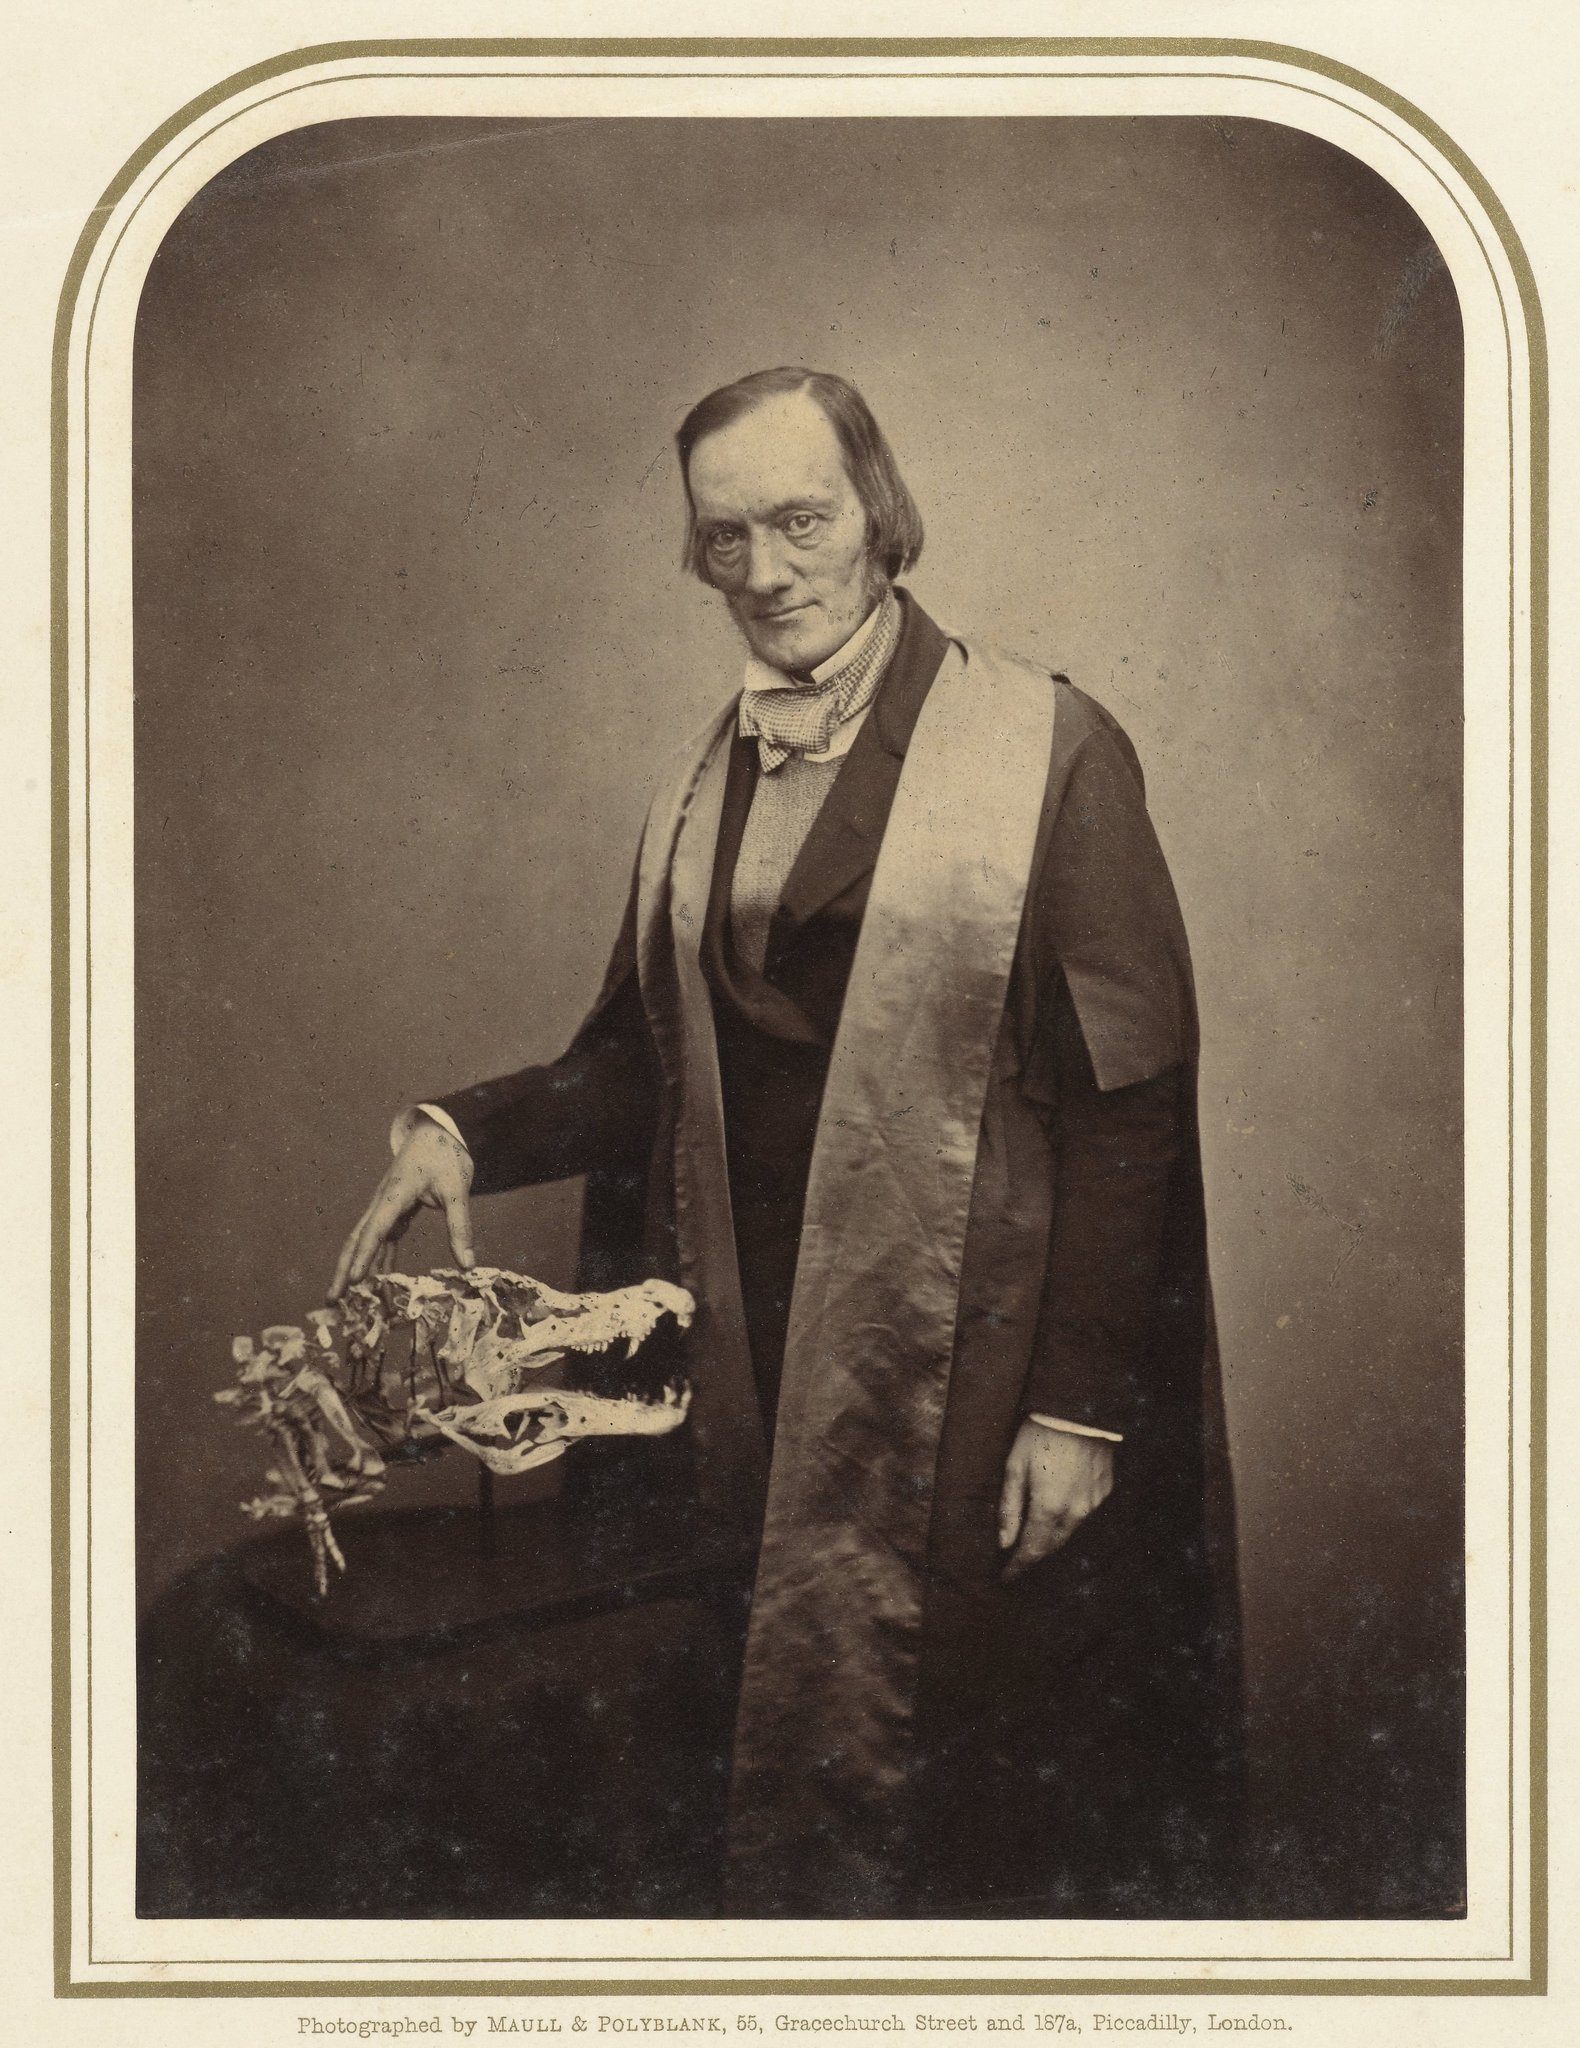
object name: photograph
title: Photographic Portraits of Living Celebrities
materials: paper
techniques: albumen print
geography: london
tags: scholar, philosopher, historical persons, great britain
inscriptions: inscription: ‘Photographed by MAULL & POLYBLANK, 55, Gracechurch Street and 187a, Piccadilly, London.’, name: ‘ROYAL SOCIETY/ N.S.W.’